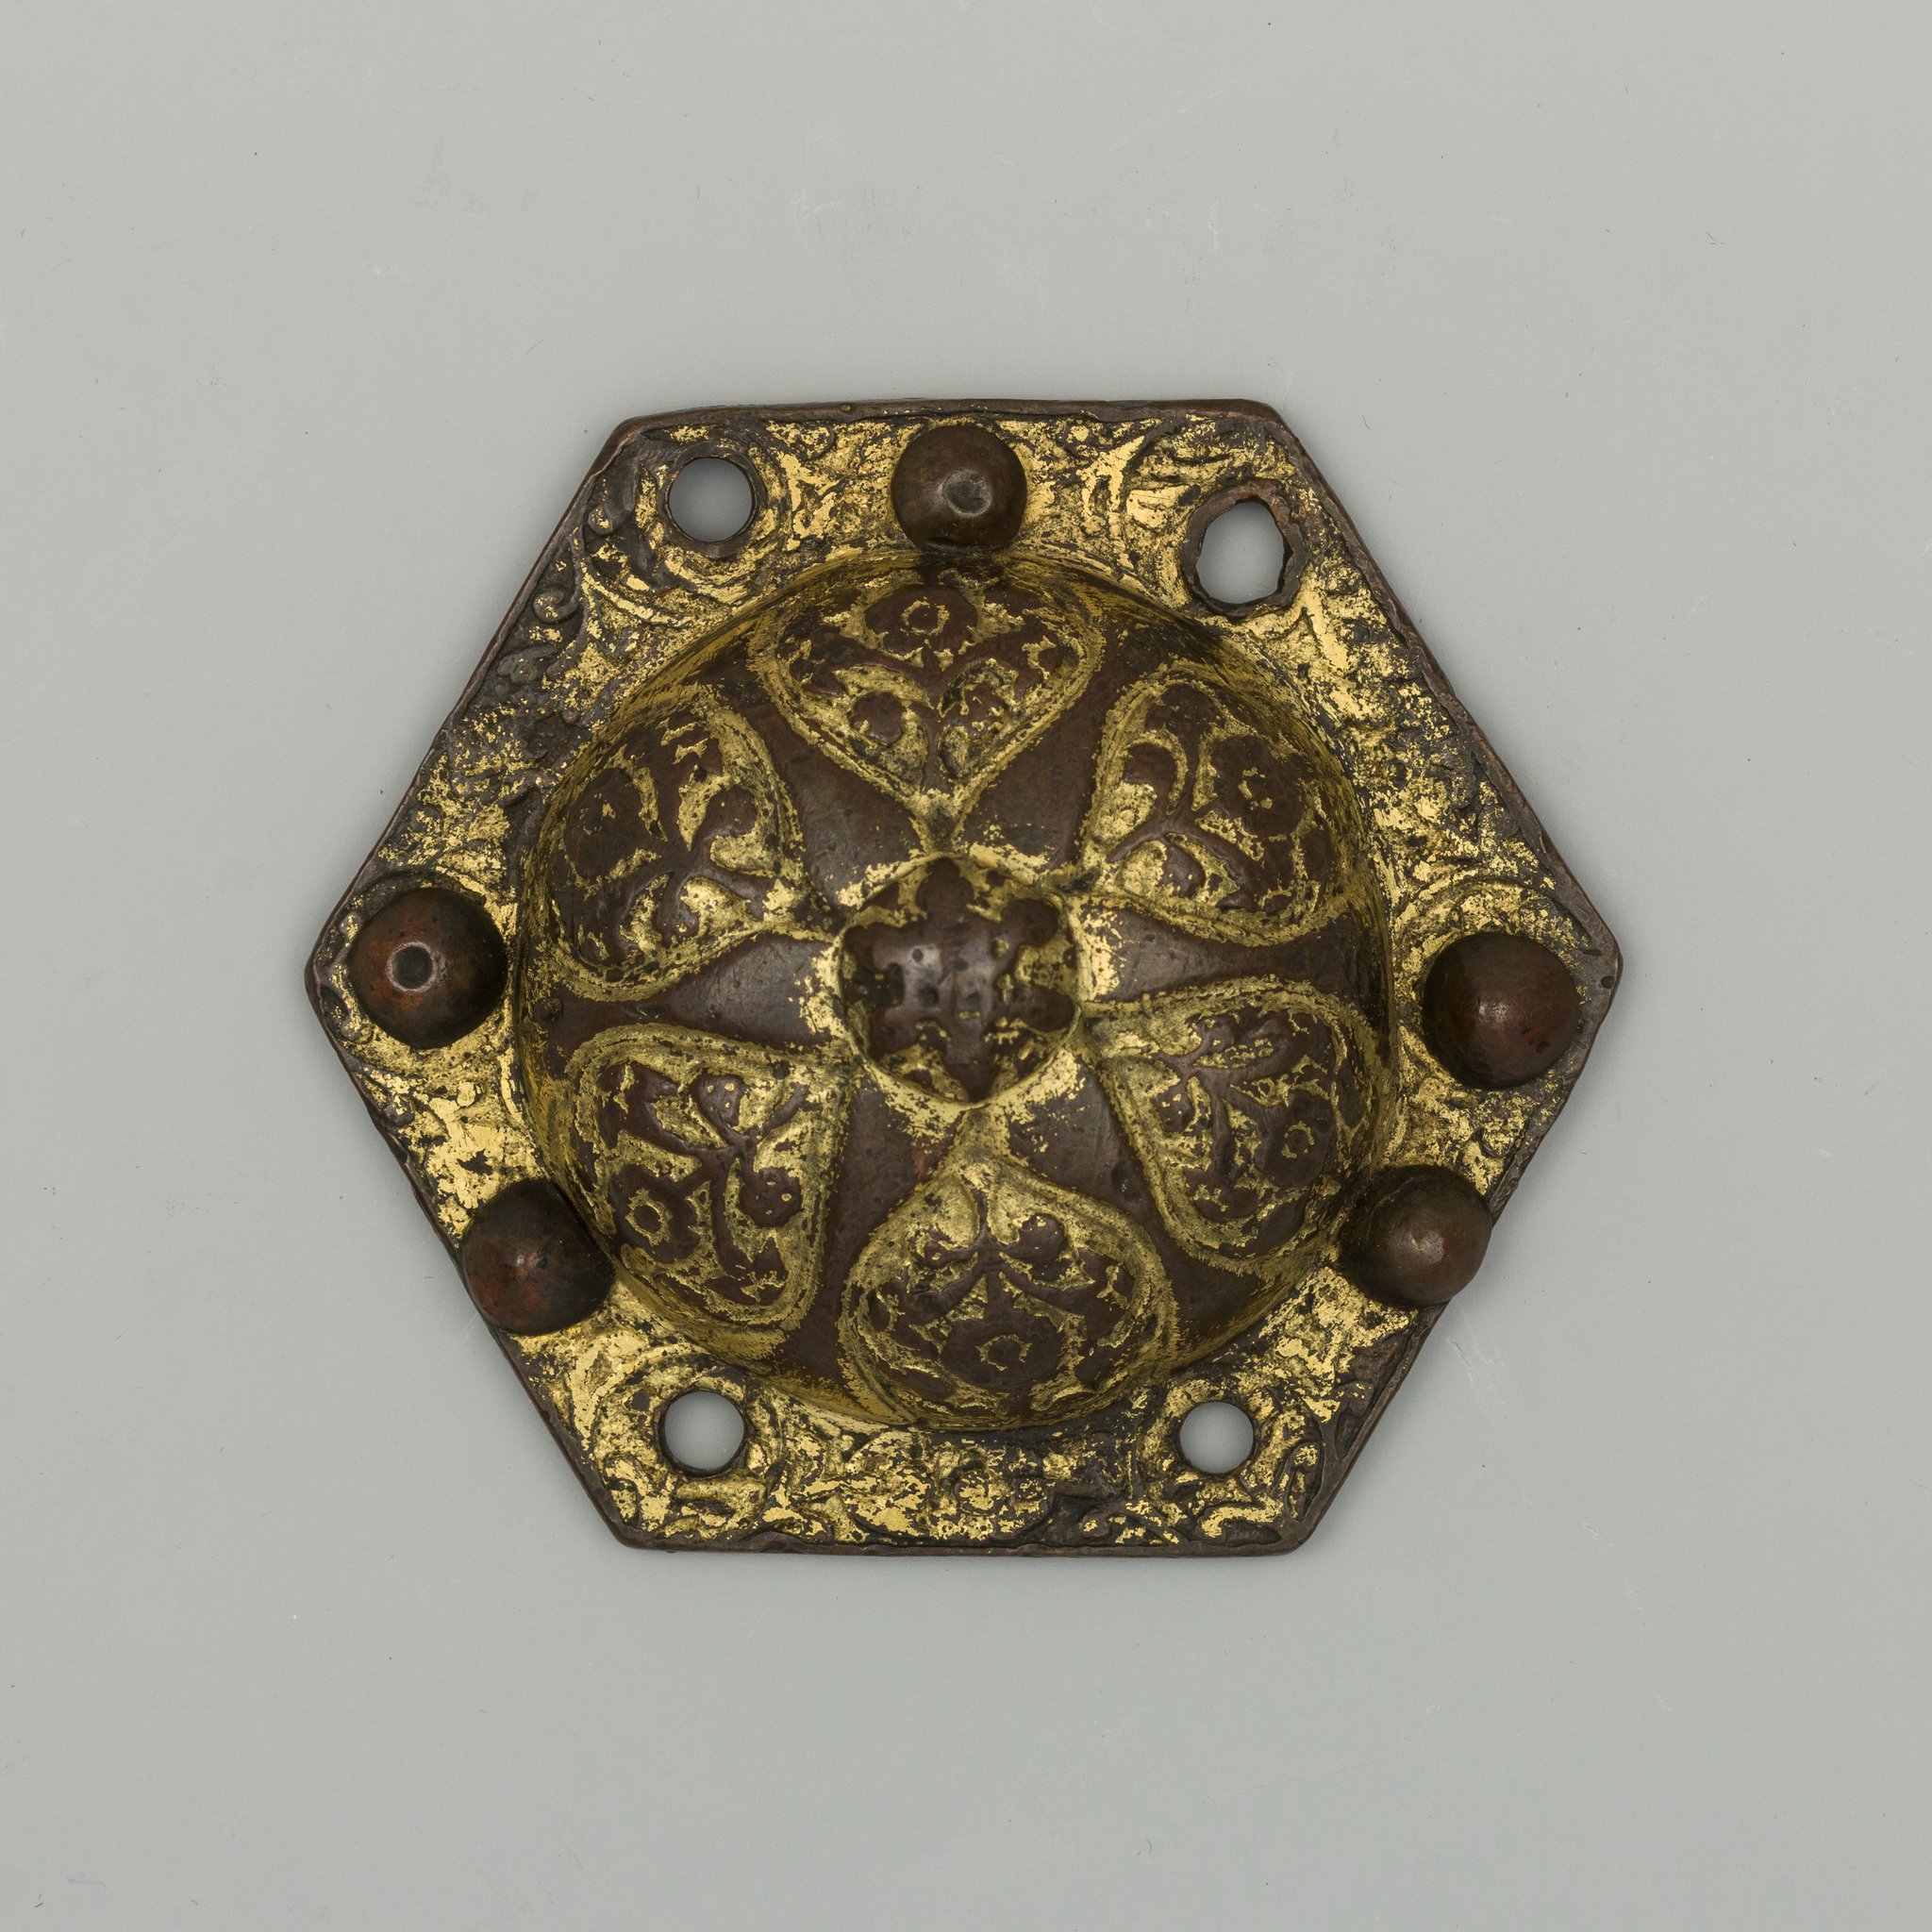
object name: harness ornament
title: Boss from a Horse Breast Collar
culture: ottoman or tatar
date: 1667-1800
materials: copper alloy, gold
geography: ottoman empire